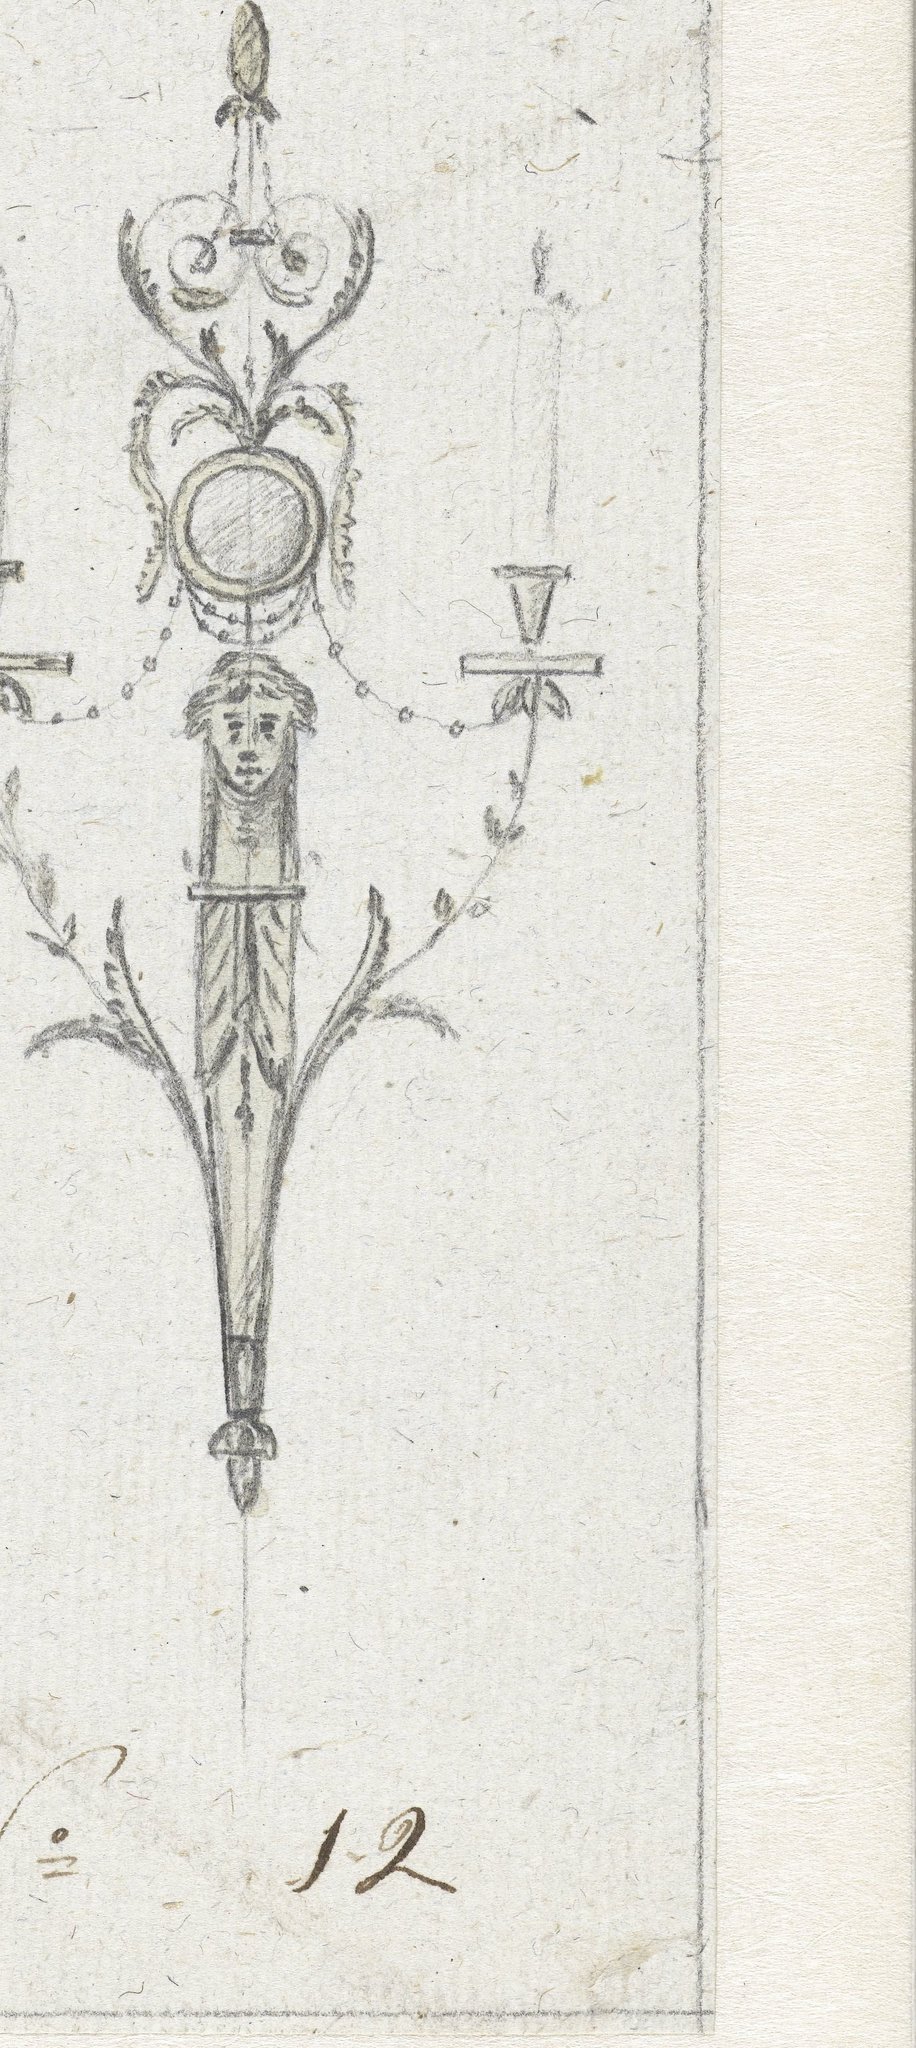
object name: drawing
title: Ontwerp voor een kandelaar (No. 12)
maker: abraham meertens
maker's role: draughtsman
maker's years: 1757-1823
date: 1776-1823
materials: paper, pencil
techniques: brush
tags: sconce, wall lamp